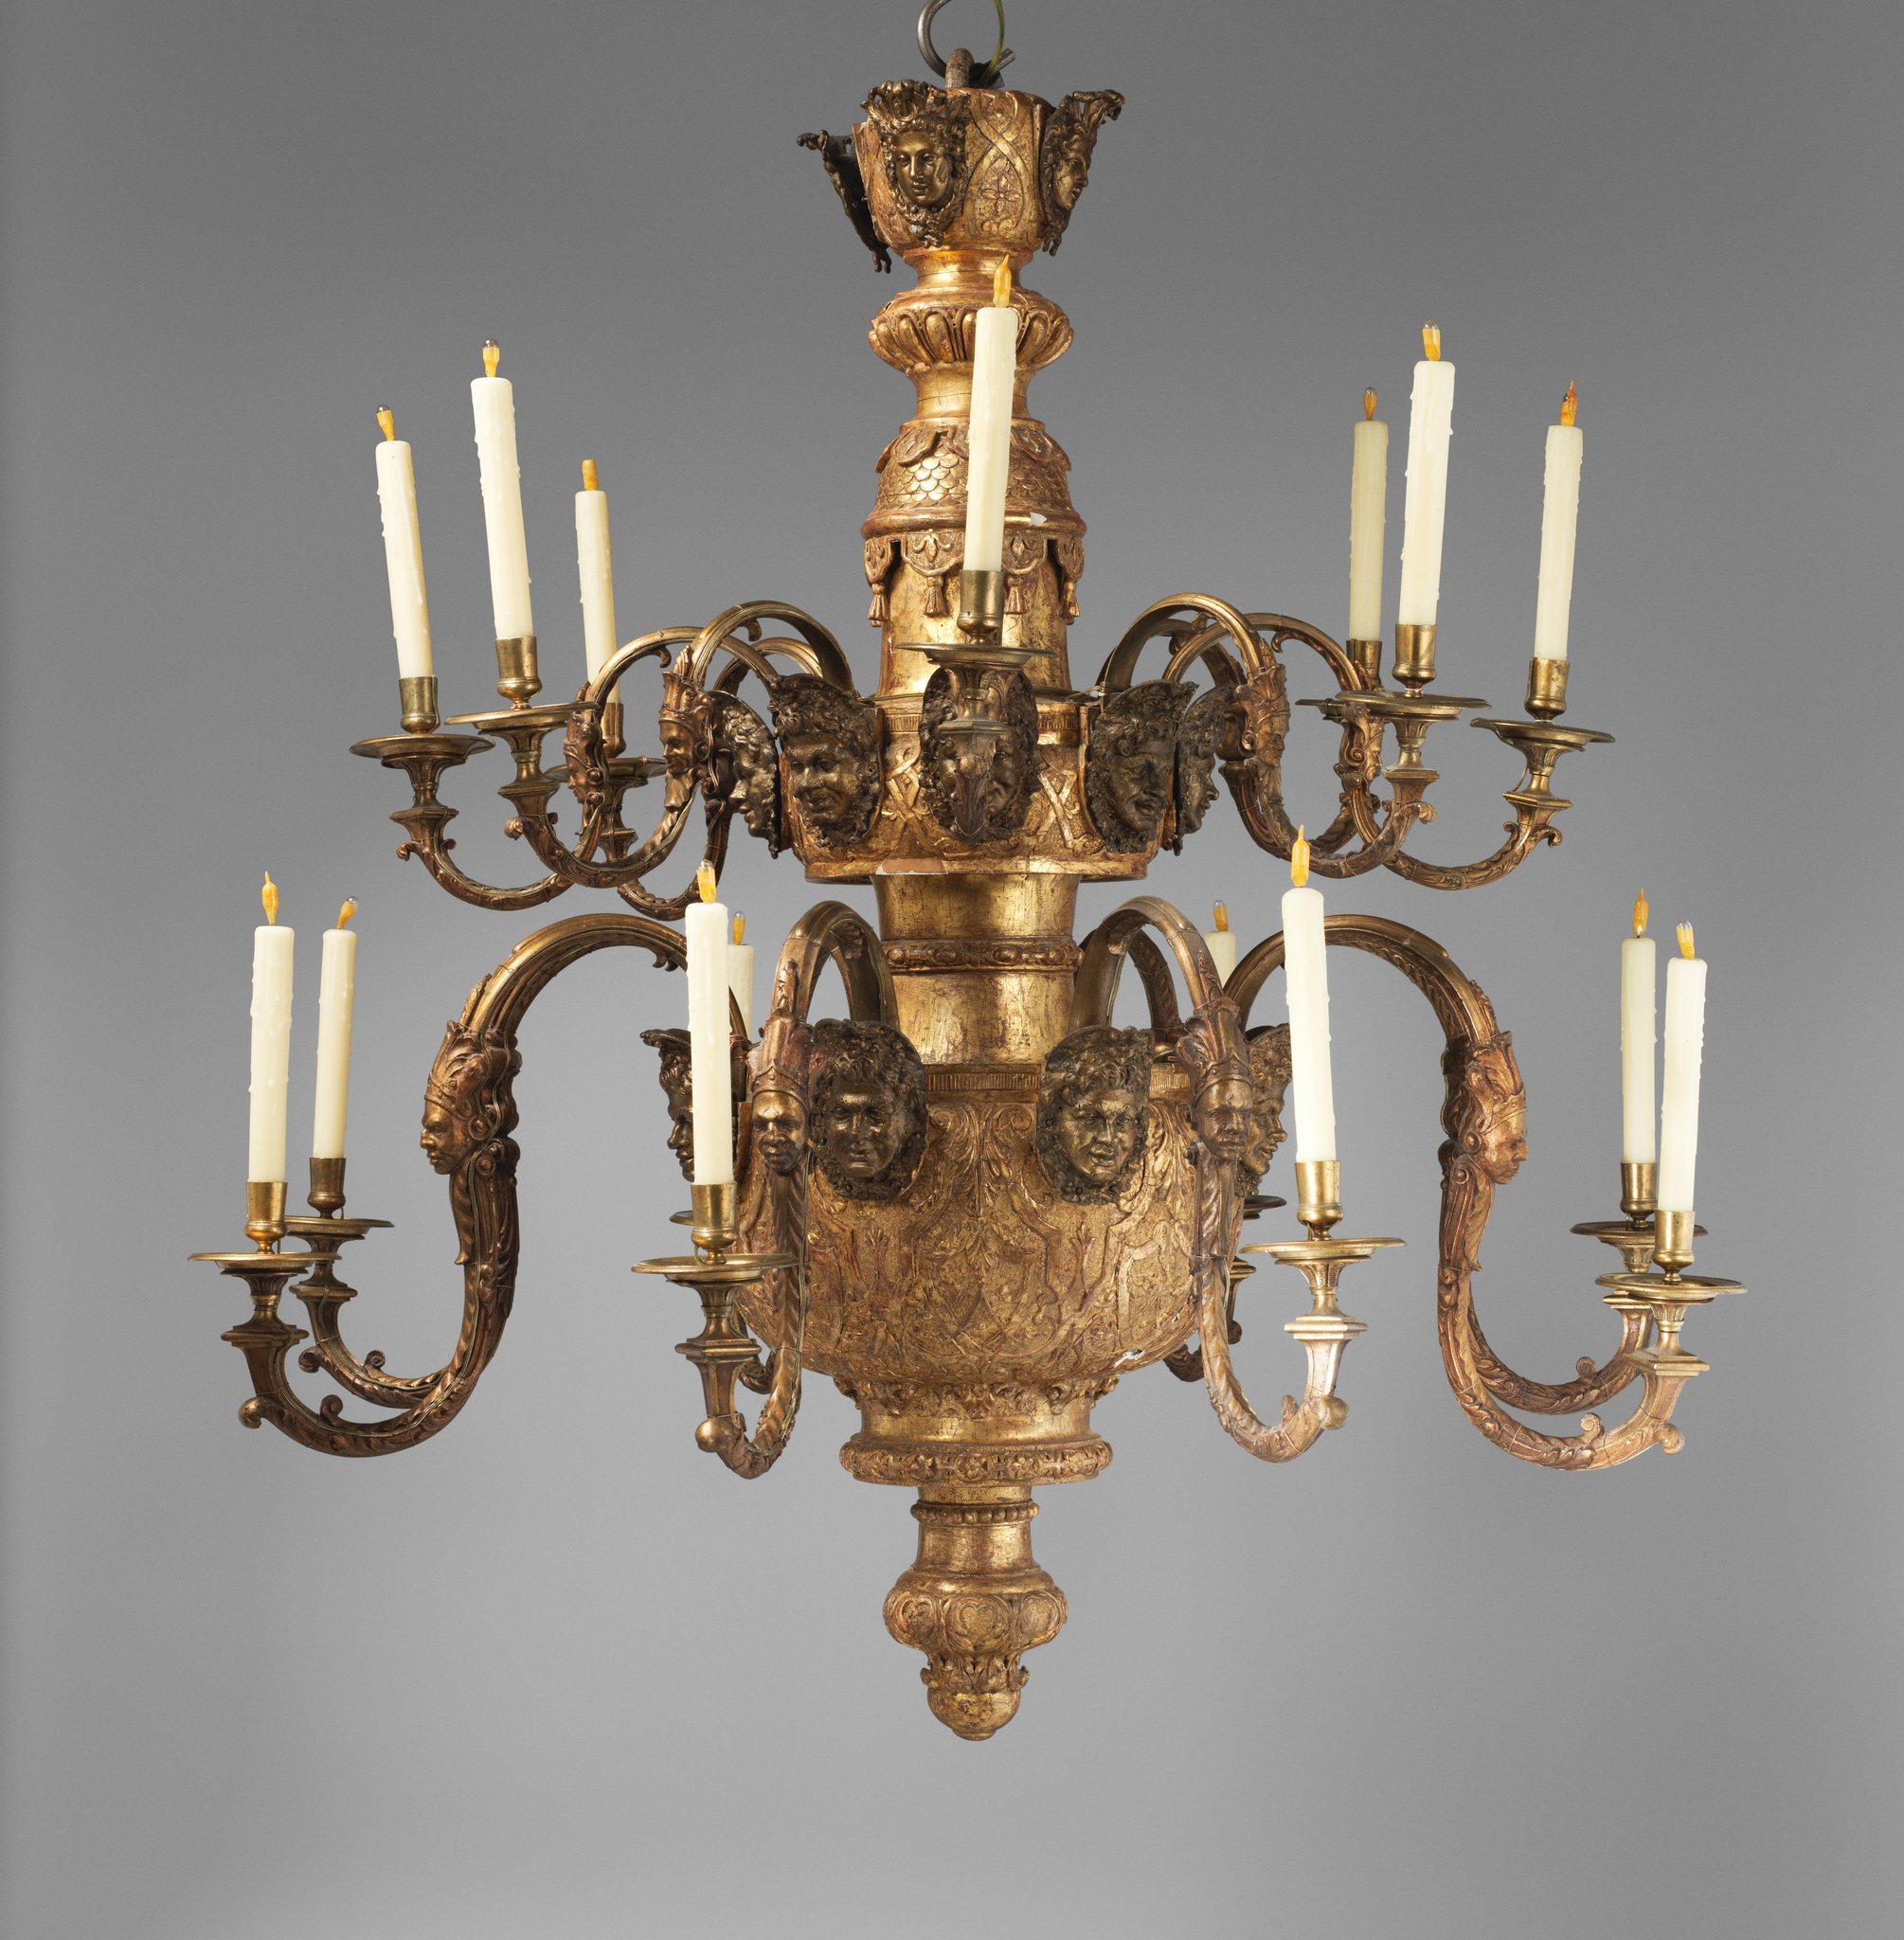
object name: chandelier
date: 1690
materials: gesso, gilt, lead, metal, wood